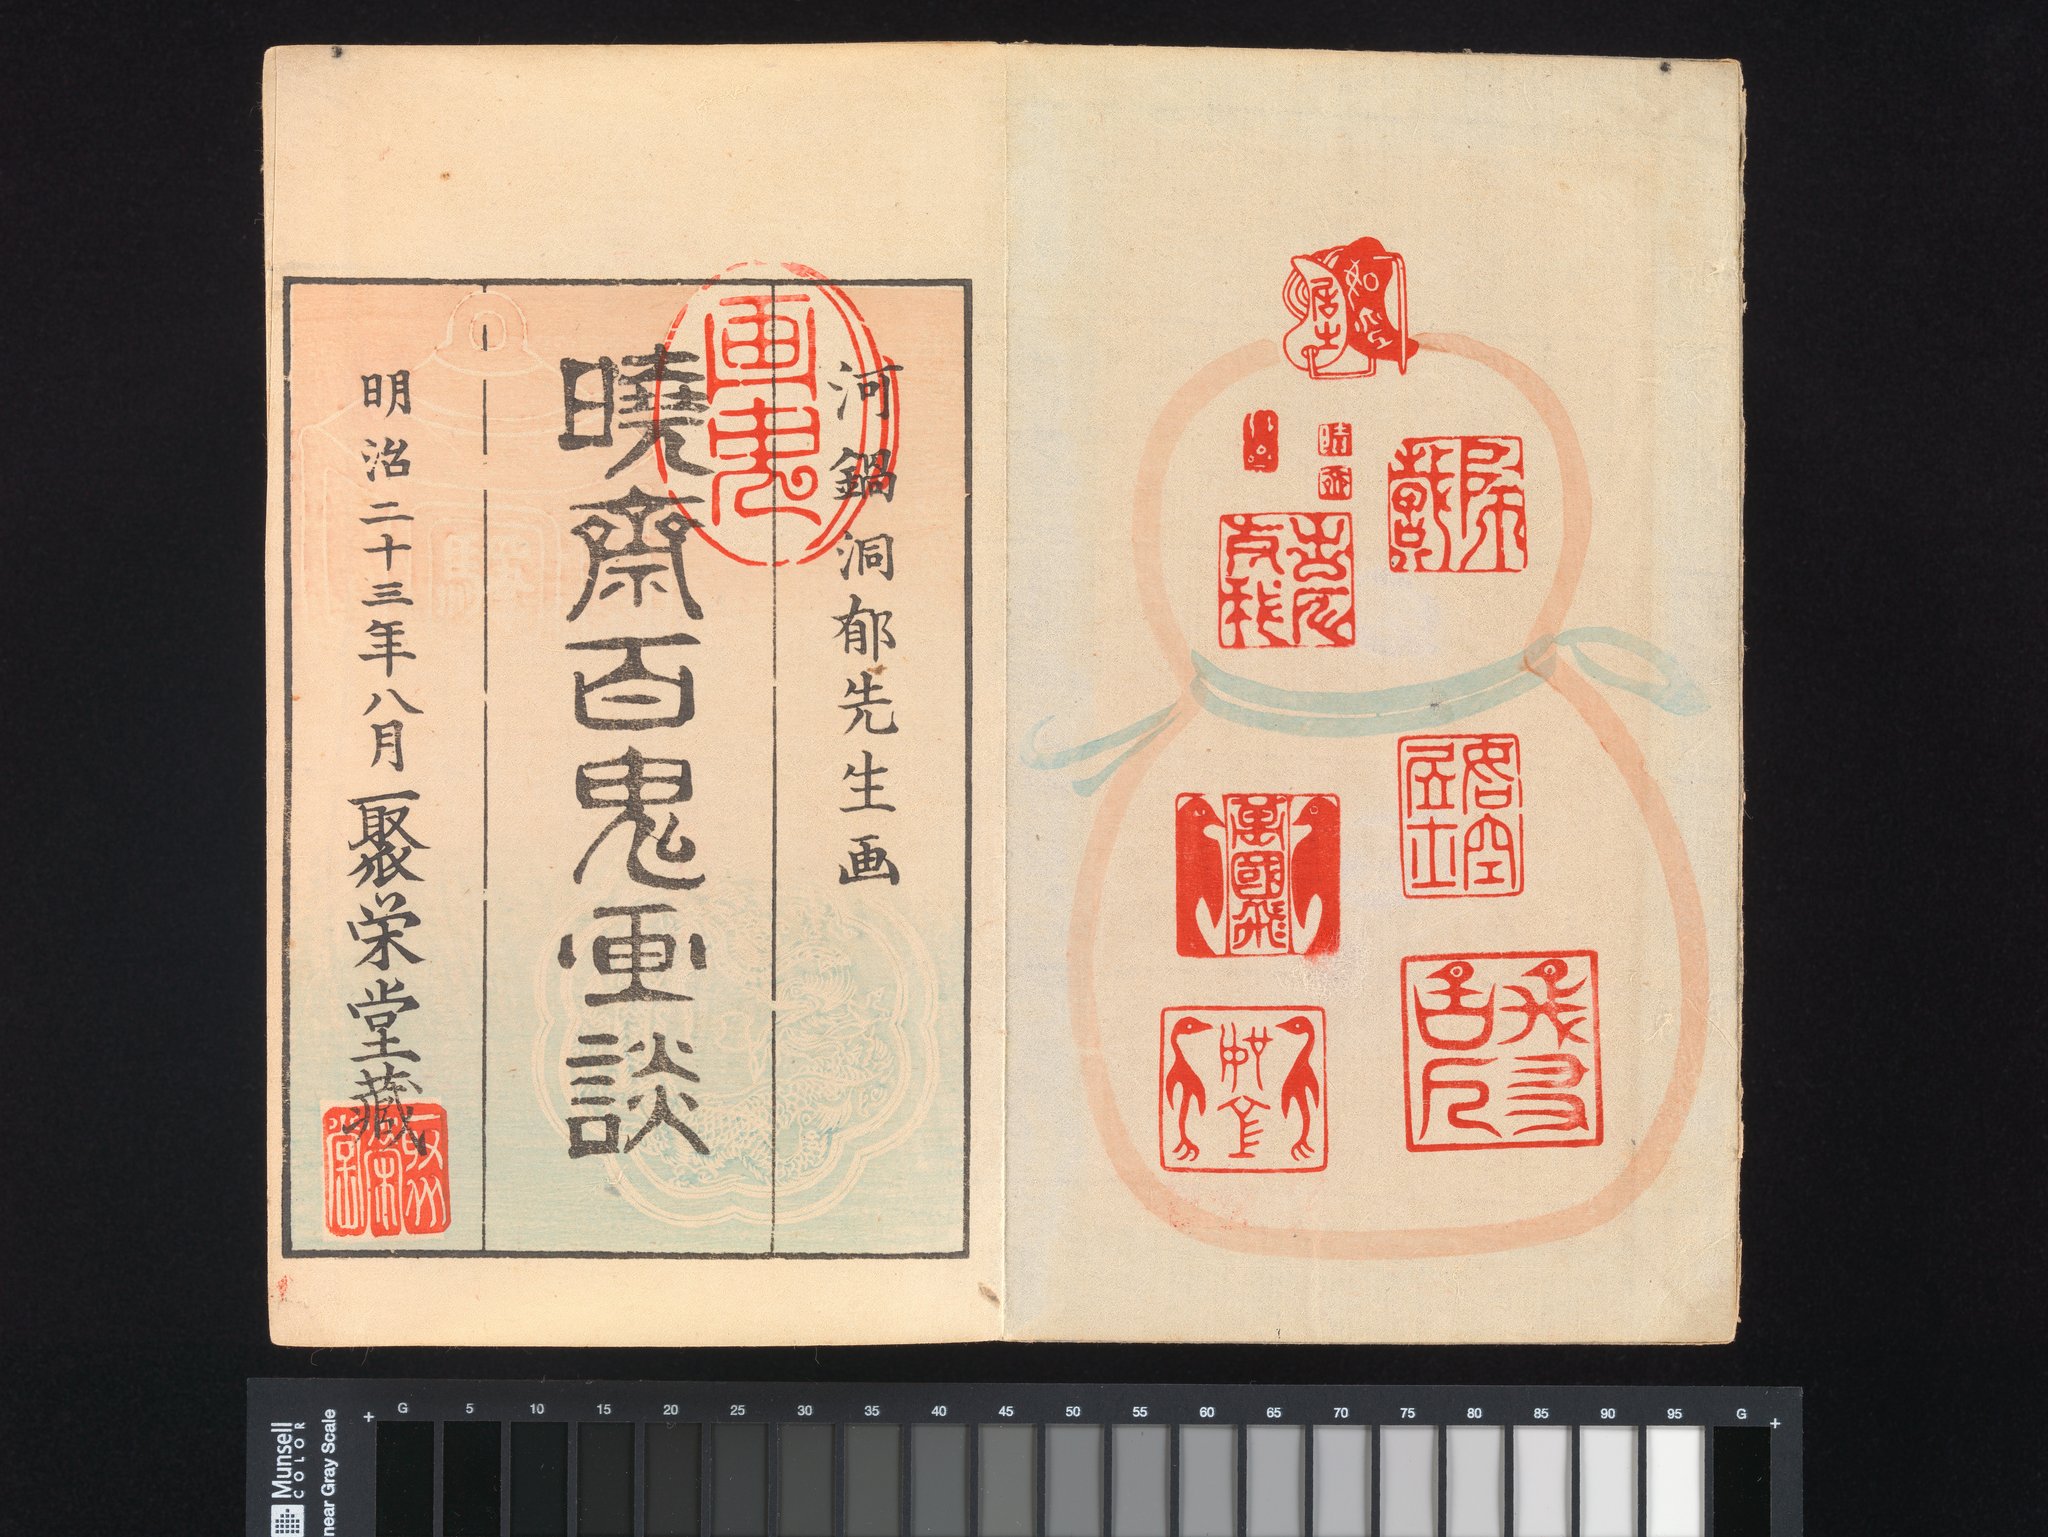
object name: illustrated book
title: Kyōsai’s Pictures of One Hundred Demons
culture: japanese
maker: kawanabe kyōsai 河鍋暁斎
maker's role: artist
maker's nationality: japanese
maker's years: 1831-1889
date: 1890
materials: ink, paper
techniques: bookbinding, woodblock print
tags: skeletons,demons